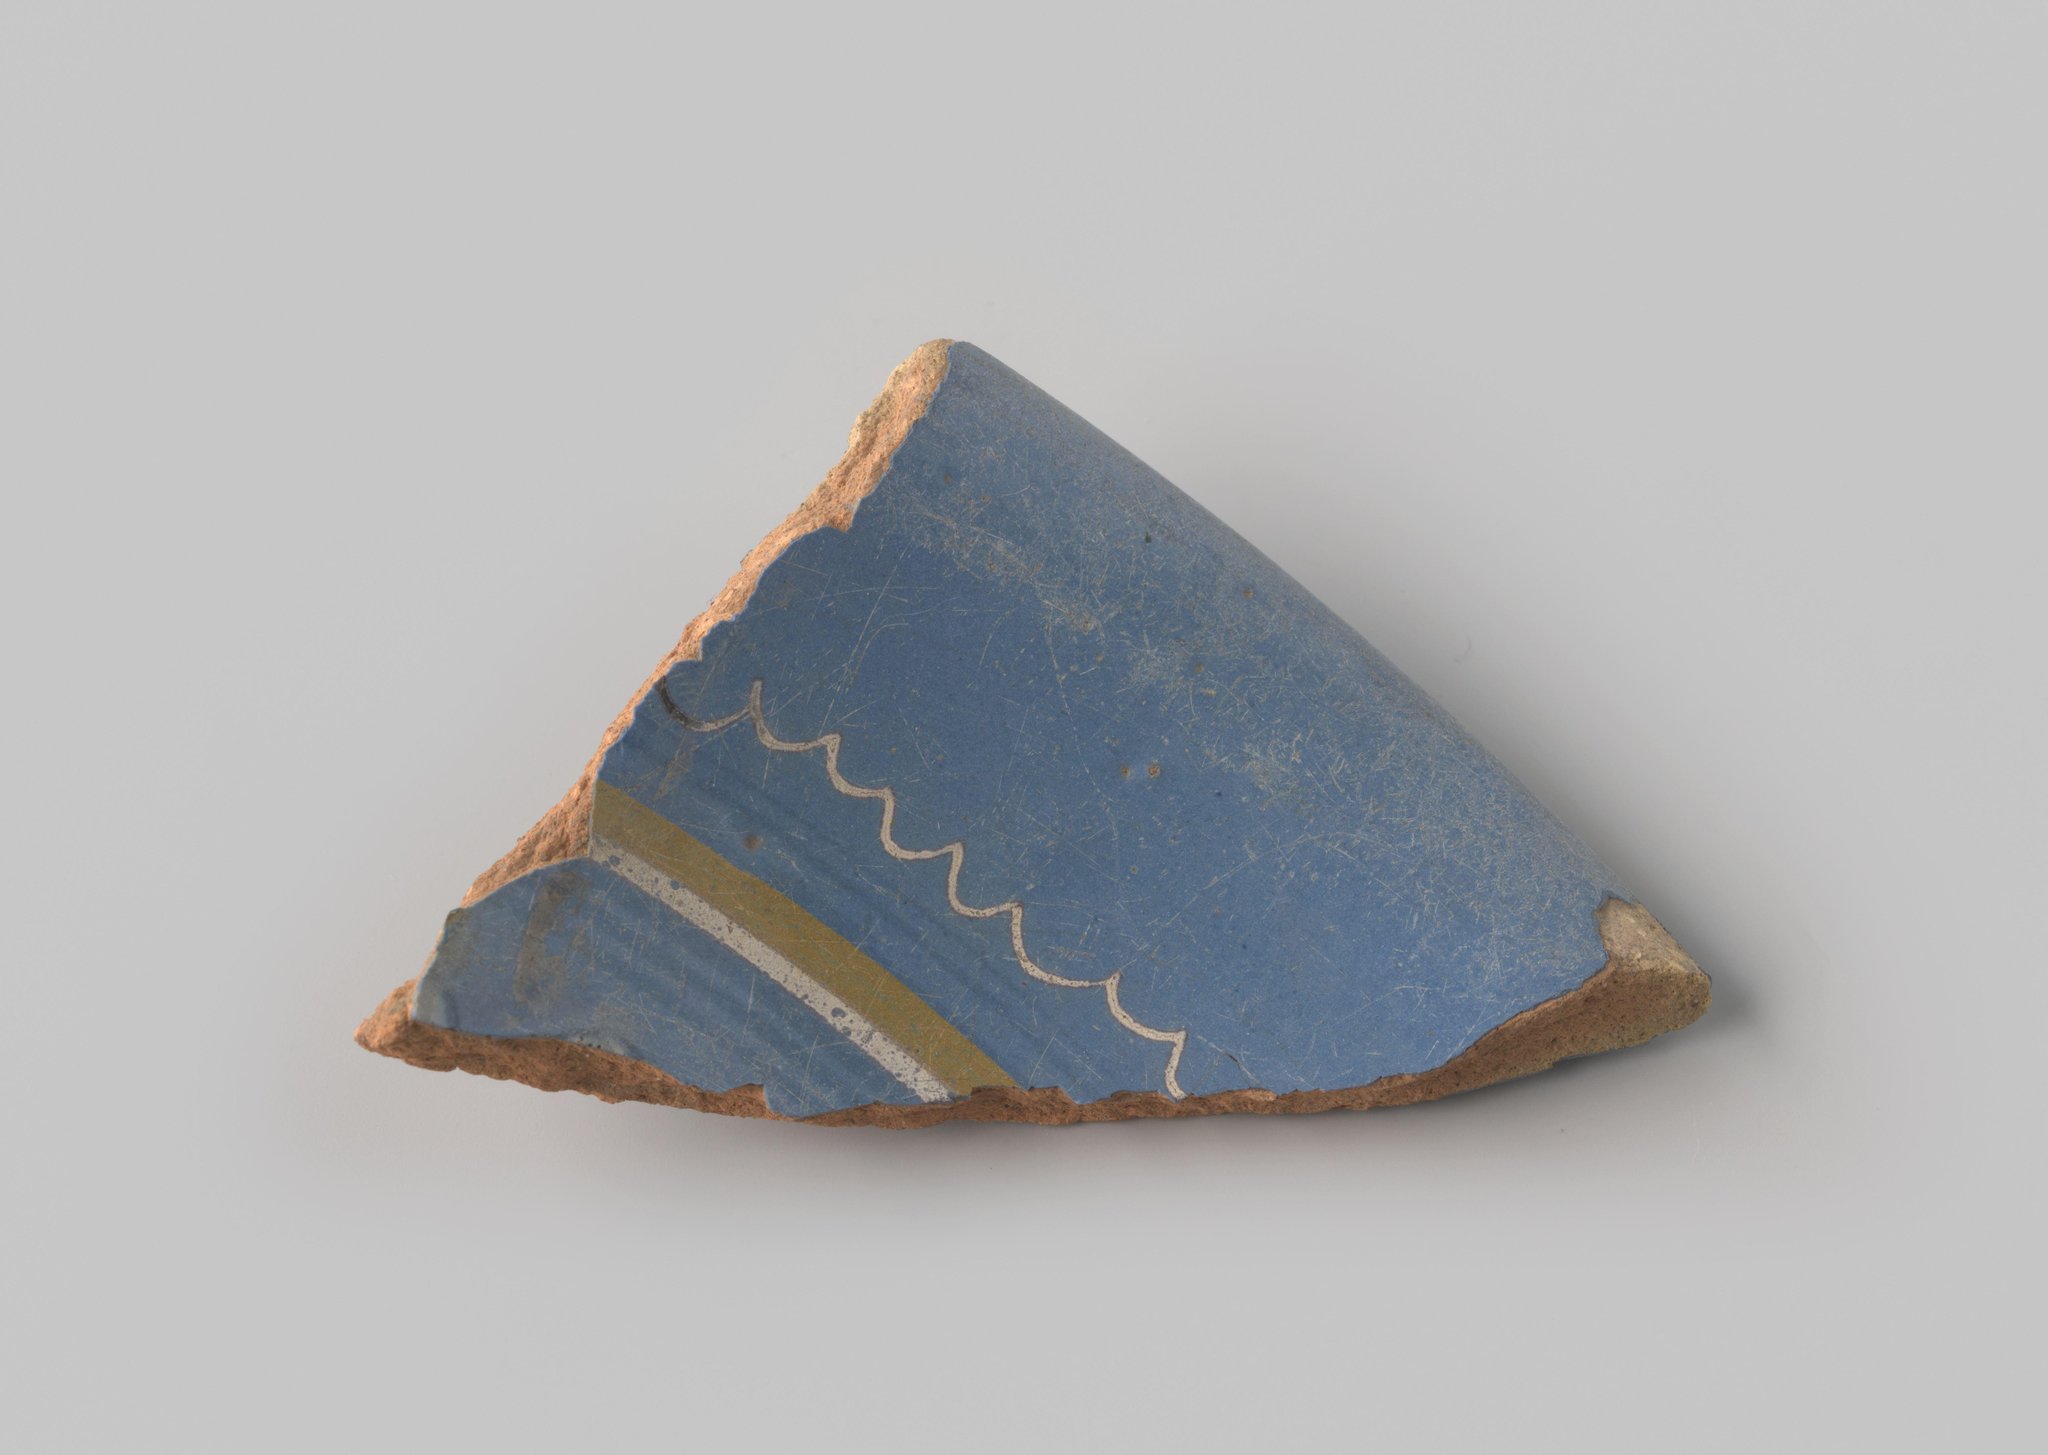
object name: fragment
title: Scherf van rossigbakkend aardewerk, aan de bovenzijde voorzien van blauw glazuur, beschilderd met rechte en gegolfde strepen in geel, blauw en wit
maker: Anonymous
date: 1600-1650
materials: earthenware, glaze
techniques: maiolica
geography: northern netherlands